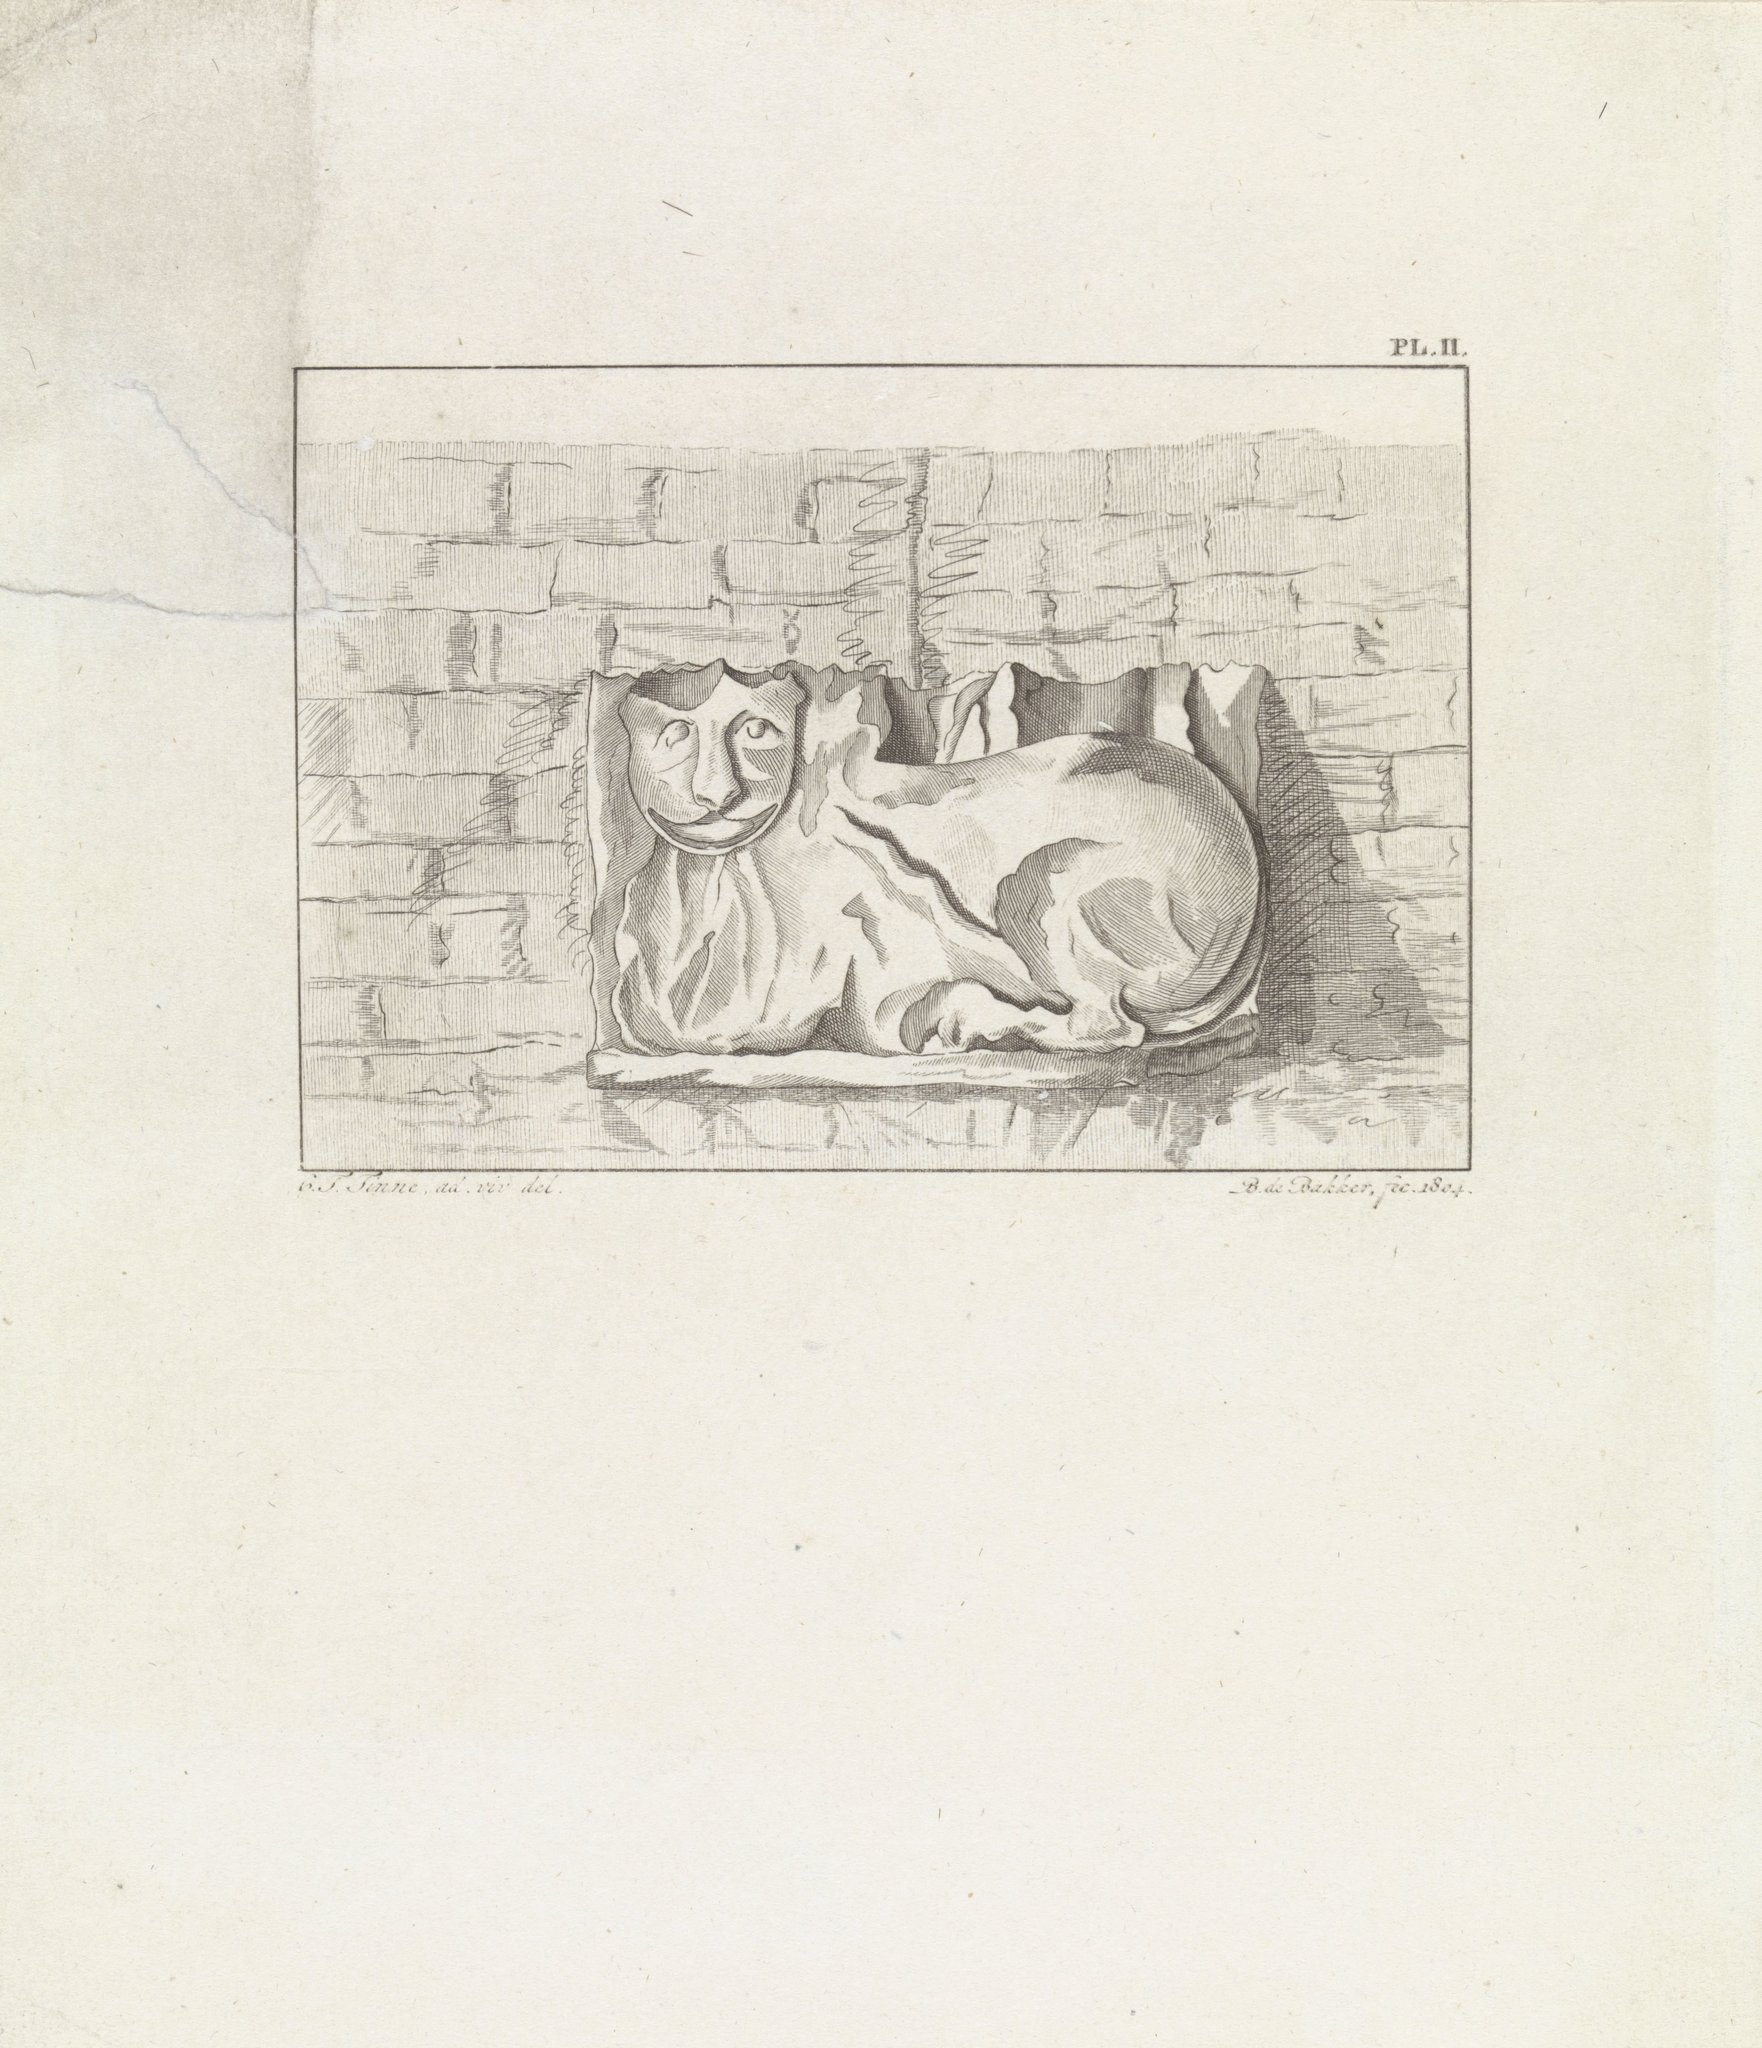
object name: print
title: Reliëf met liggende leeuw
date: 1804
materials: paper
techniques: etching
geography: amsterdam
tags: beasts of prey, predatory animals: lion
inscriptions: date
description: Prent naar tekening van Chrétien Théodore Tinne. Gebruikt voor onbekende uitgave, pl. 2.